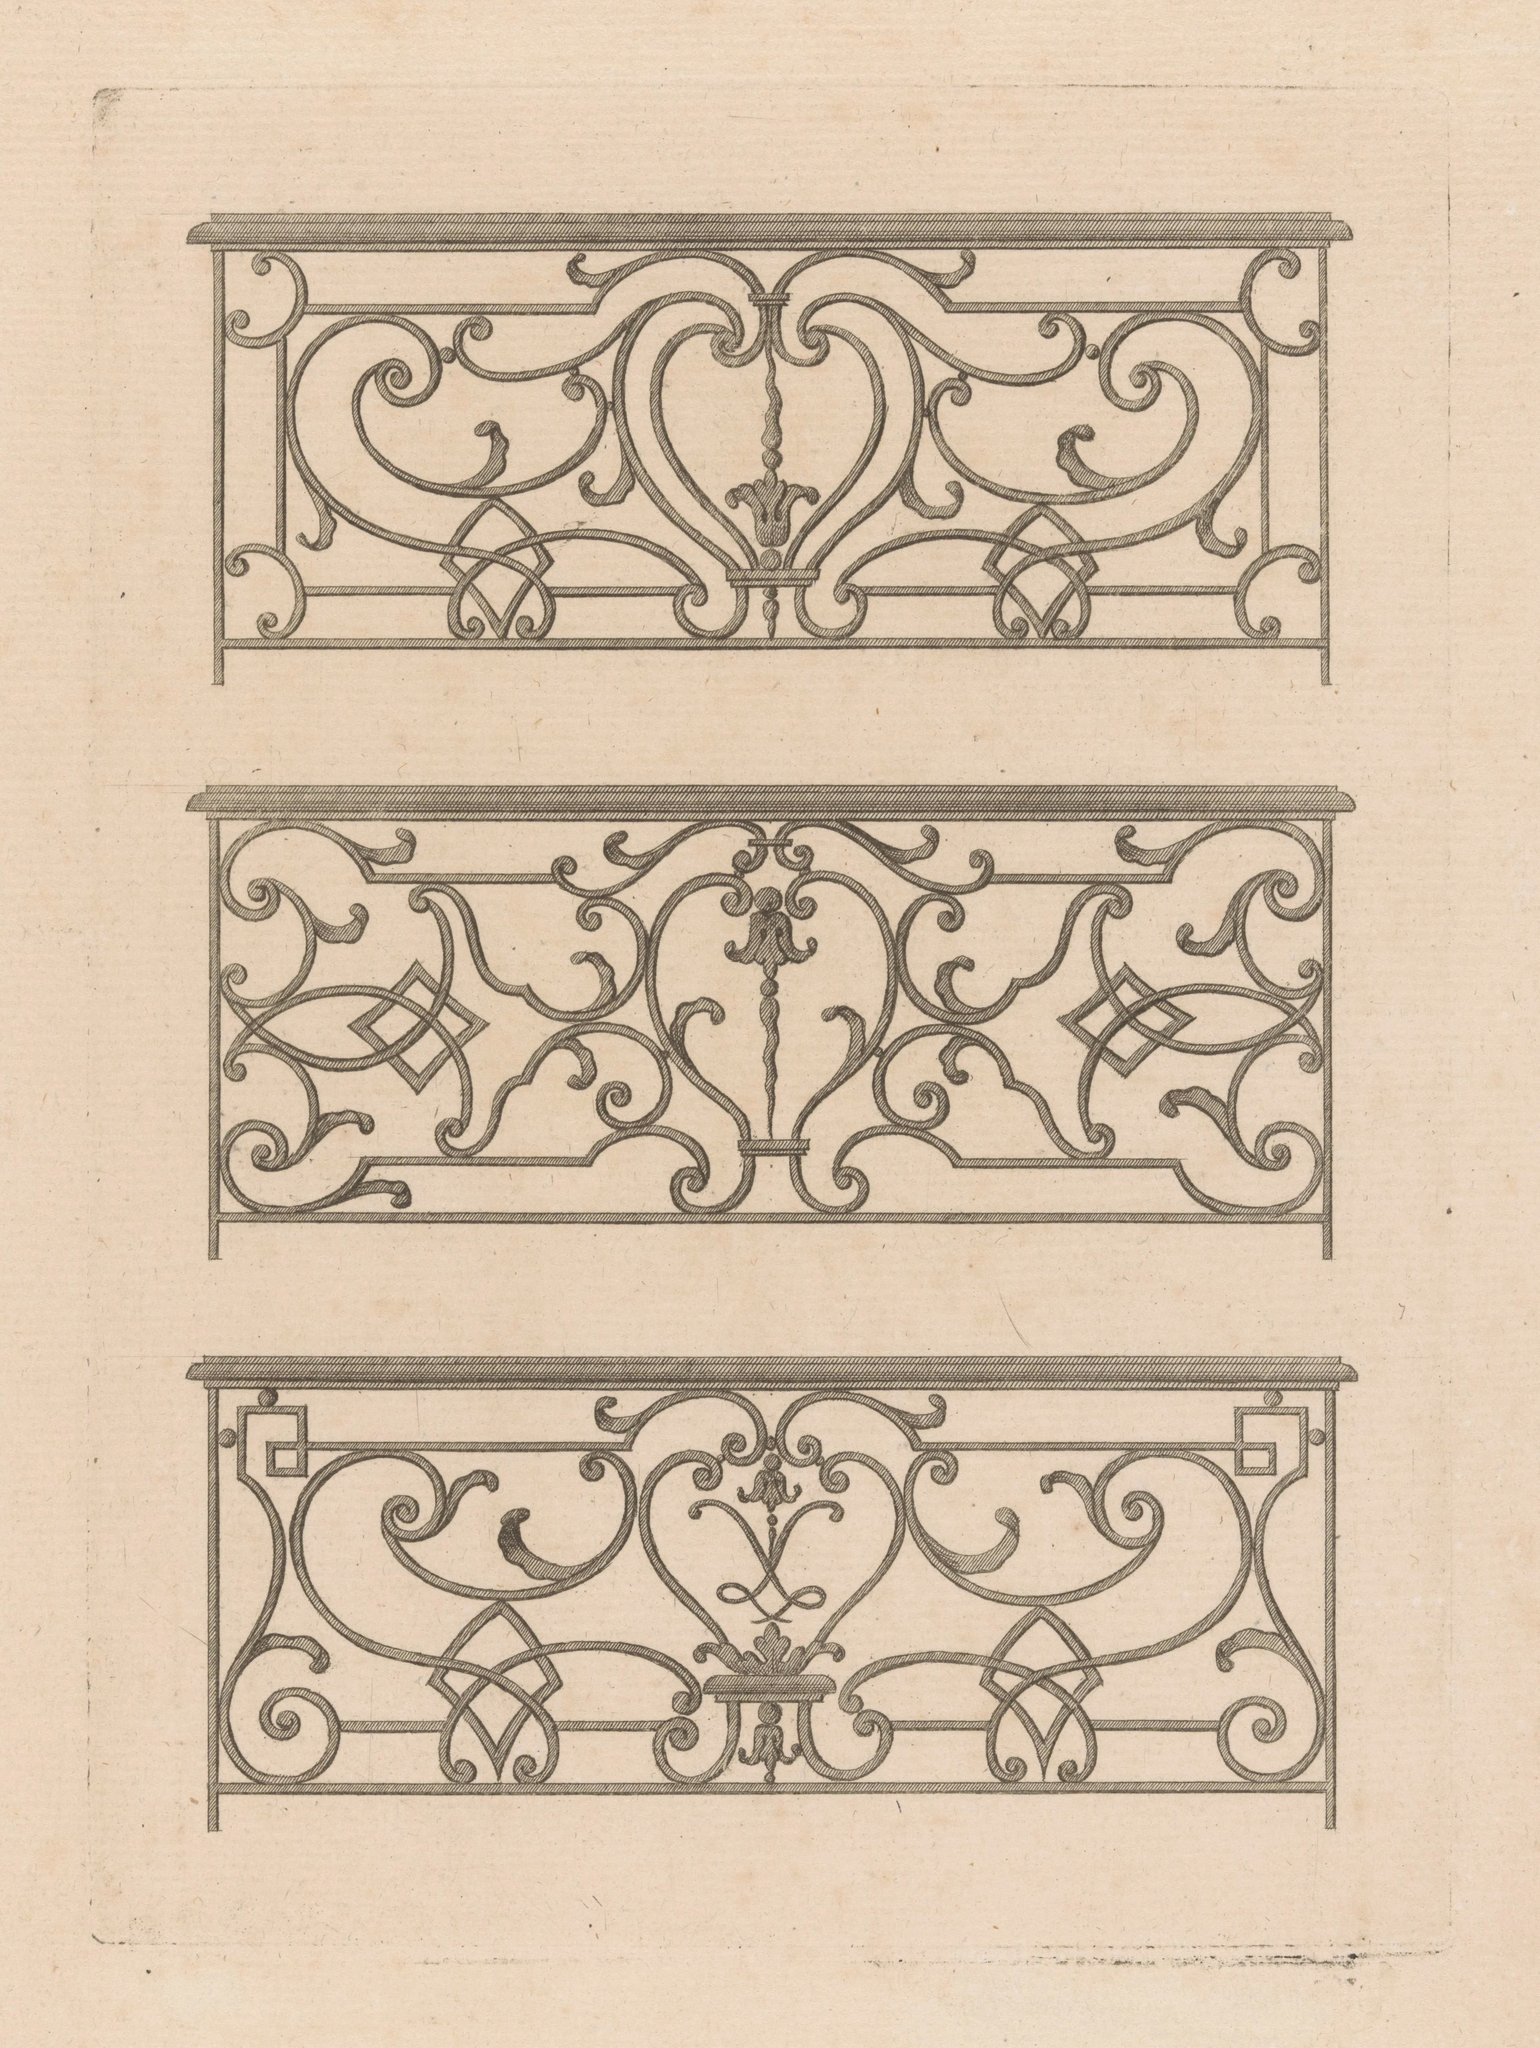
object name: print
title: Balcon d'un nouveau gout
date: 1759-1784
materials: paper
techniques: etching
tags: balustrade, balcony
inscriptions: collector's mark: Lugt 2228